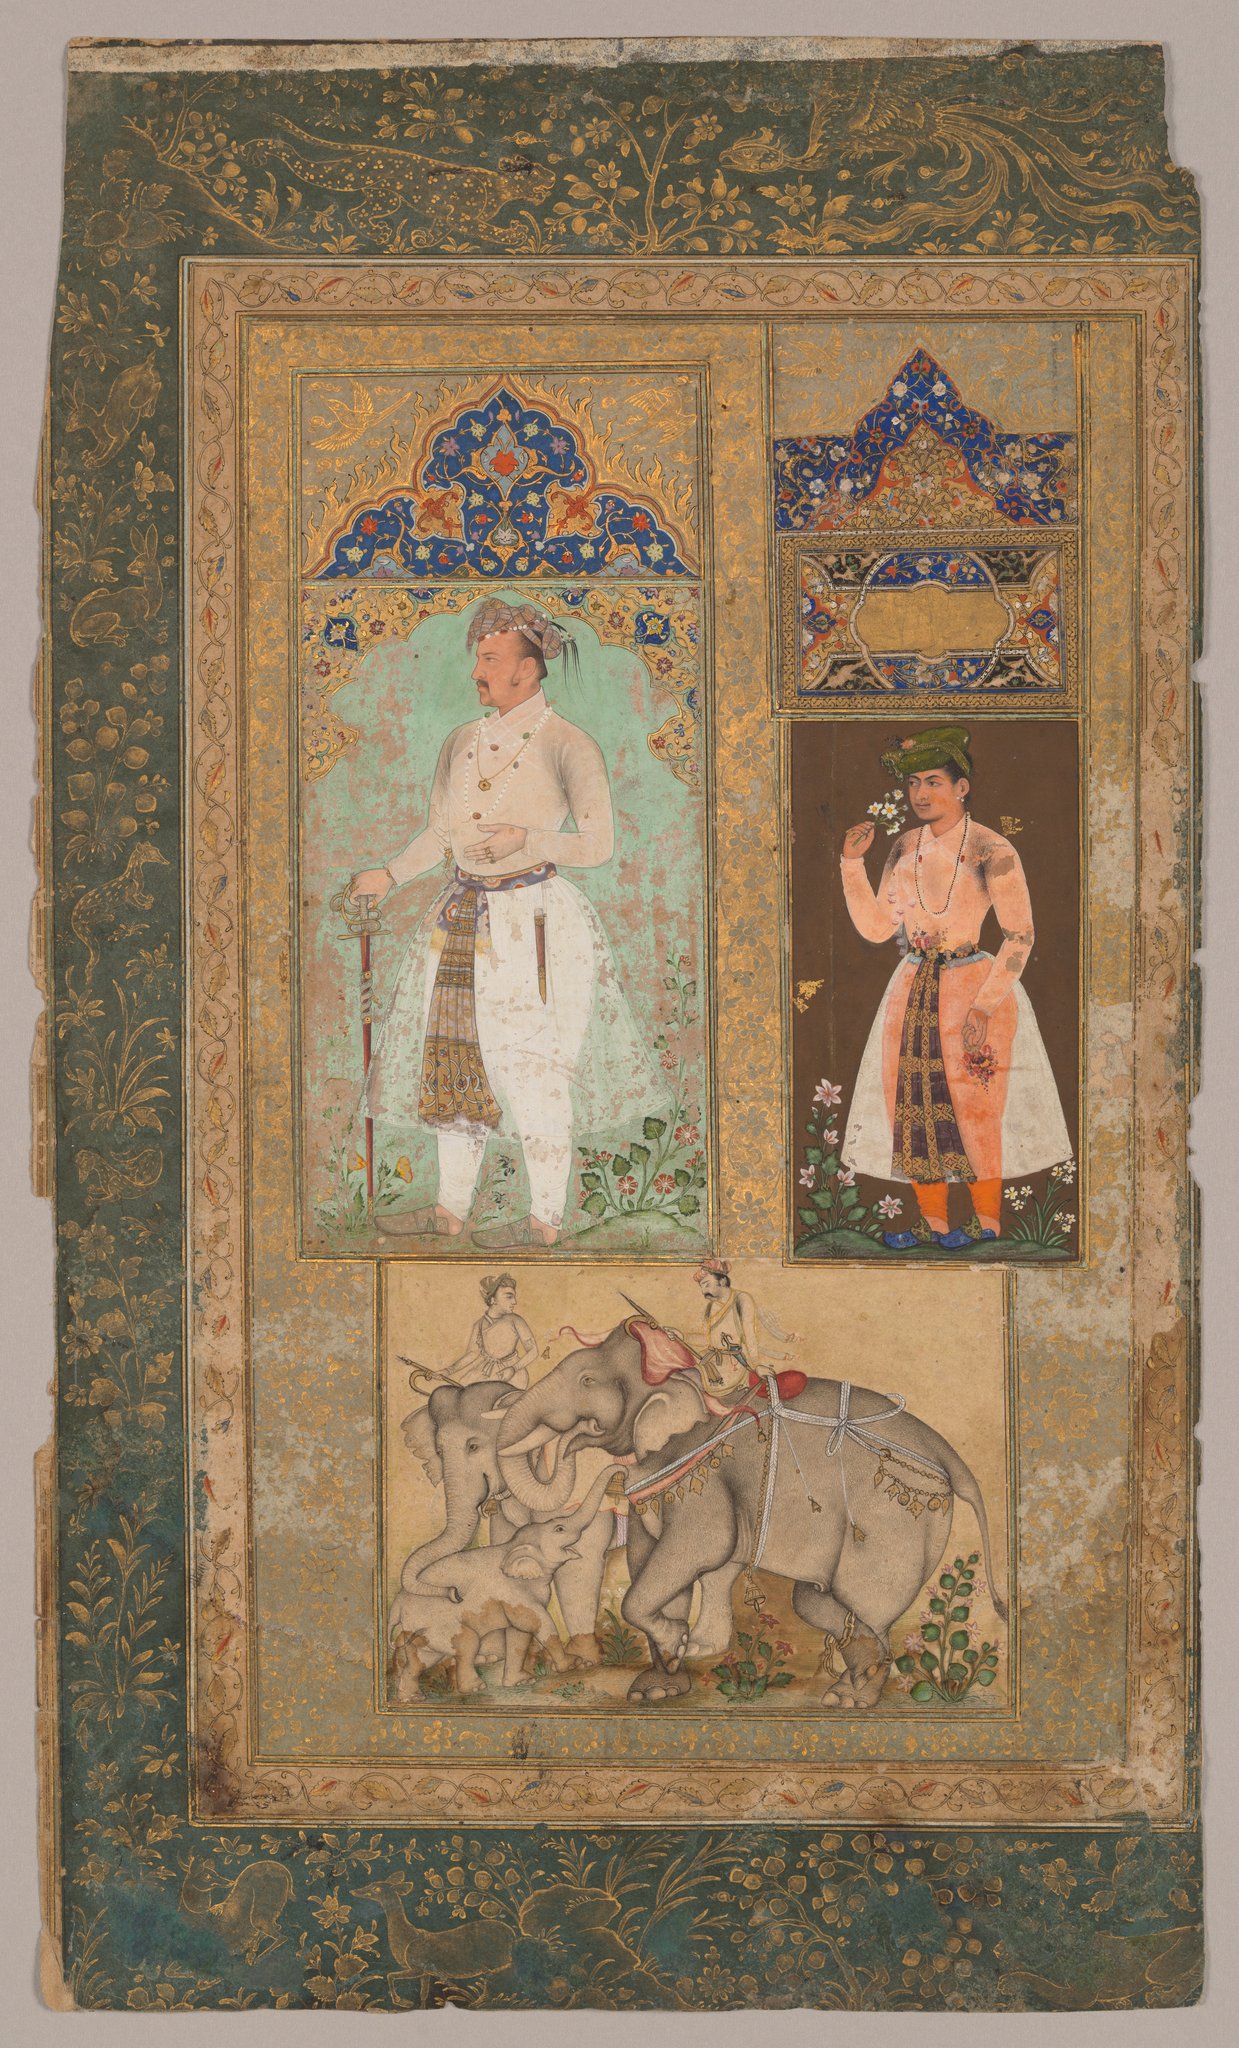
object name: illustrated album leaf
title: Composite Album Page with Standing Figure of Jahangir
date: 1601-1633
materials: gold, paint, paper, silver, watercolor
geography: india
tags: men,elephants